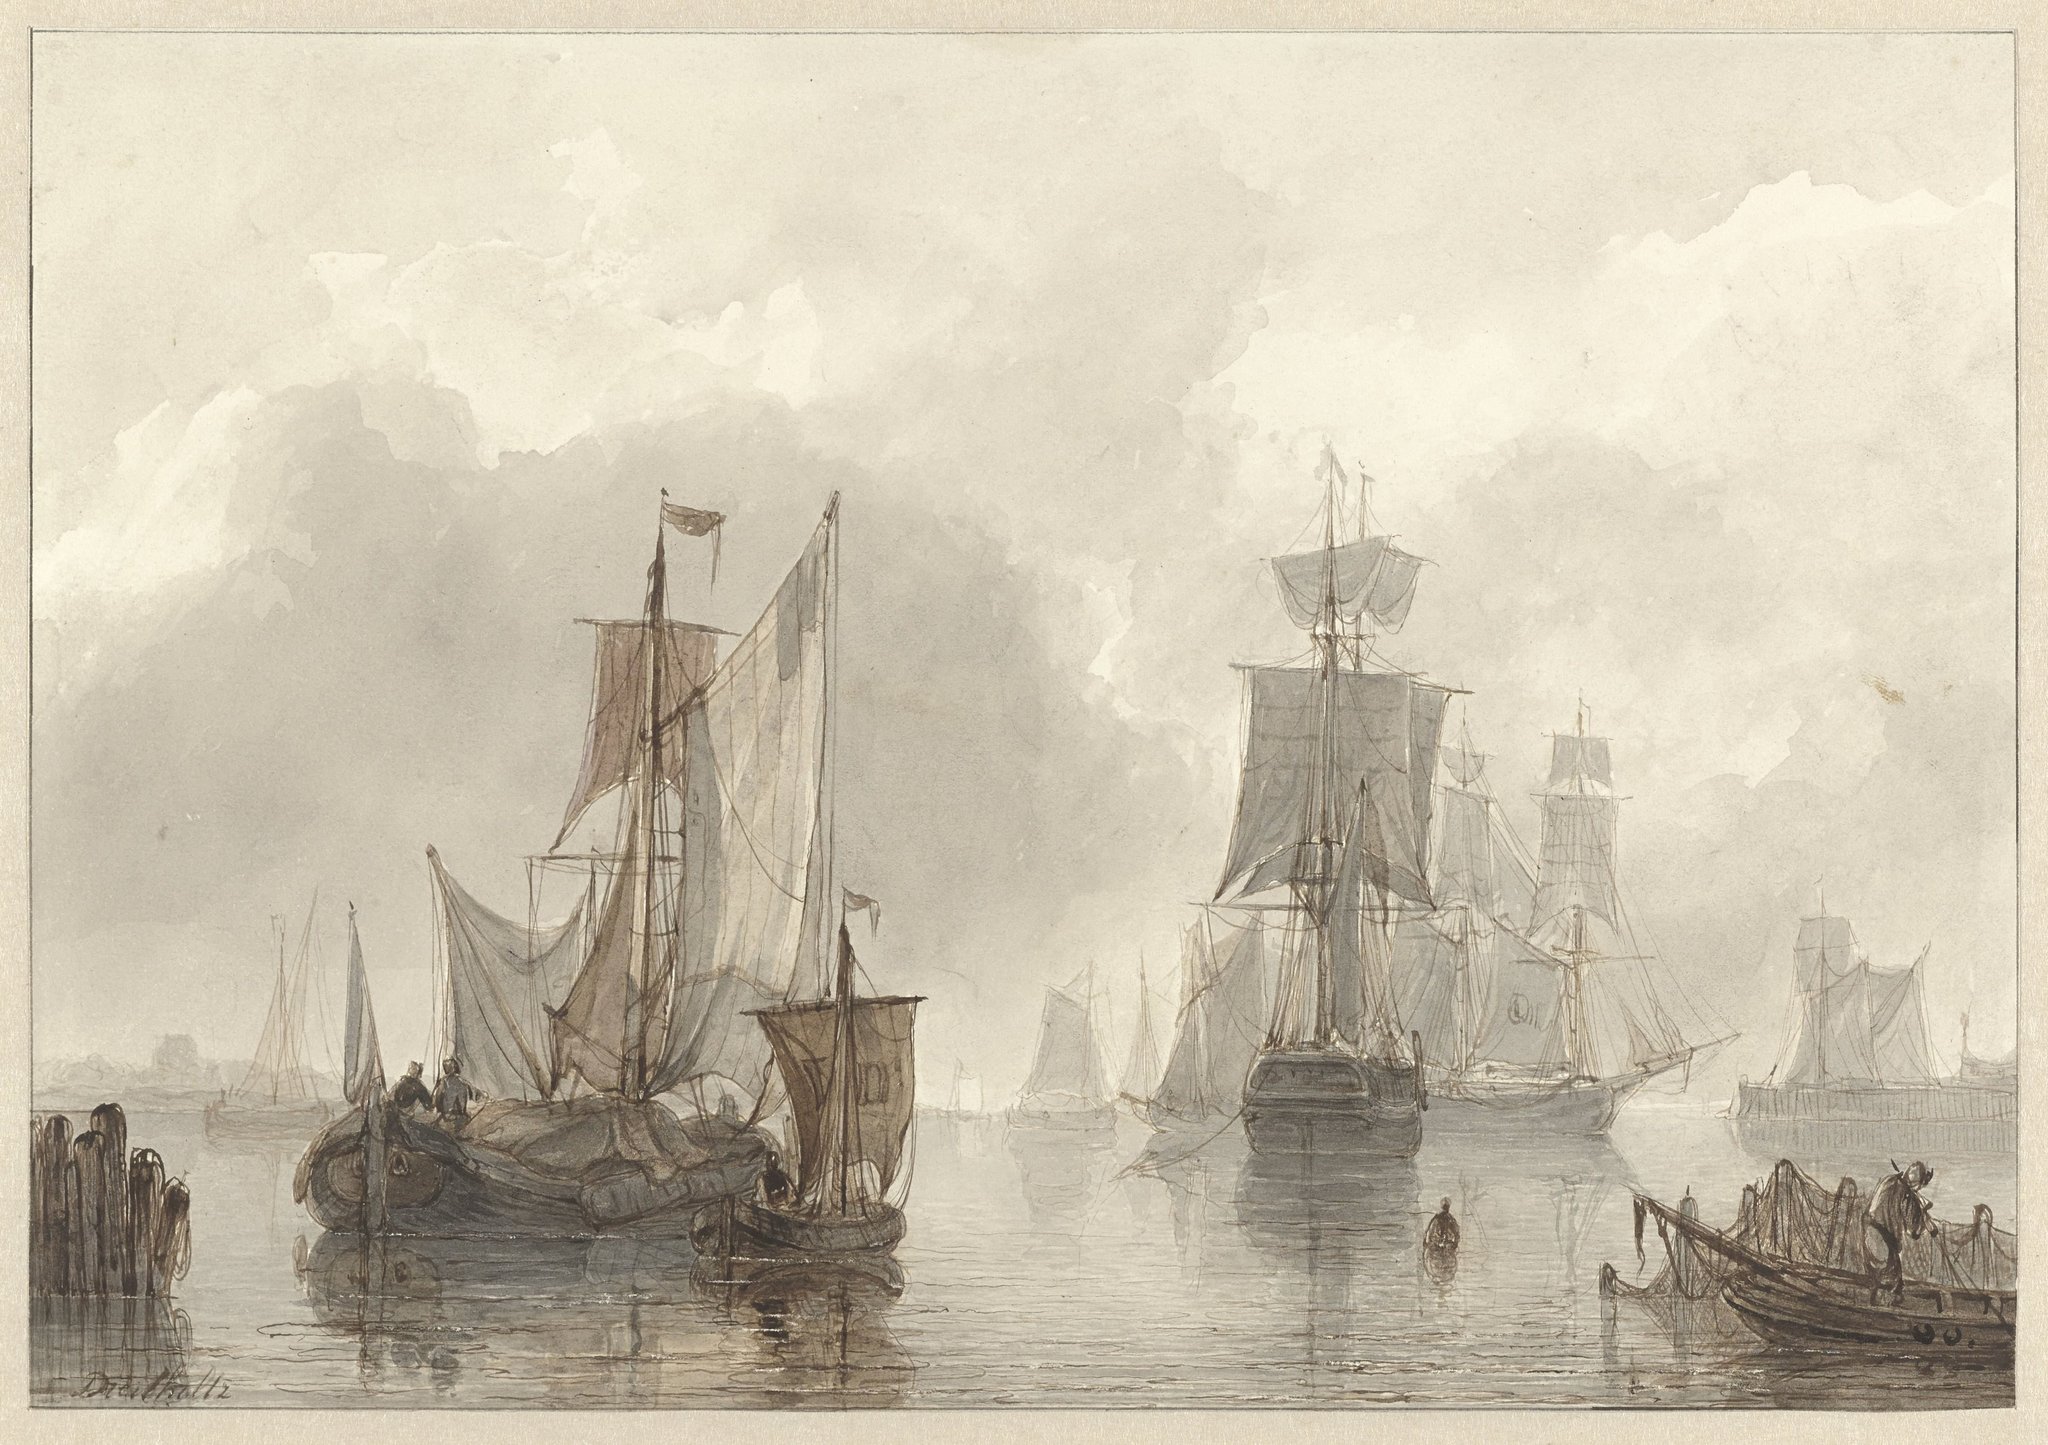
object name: drawing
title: Zeilschepen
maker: christiaan lodewijk willem dreibholtz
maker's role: draughtsman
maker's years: 1799-1874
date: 1809-1874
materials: ink, paper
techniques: brush, pen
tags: sailing-ship, sailing-boat, ship in the roads, roadstead